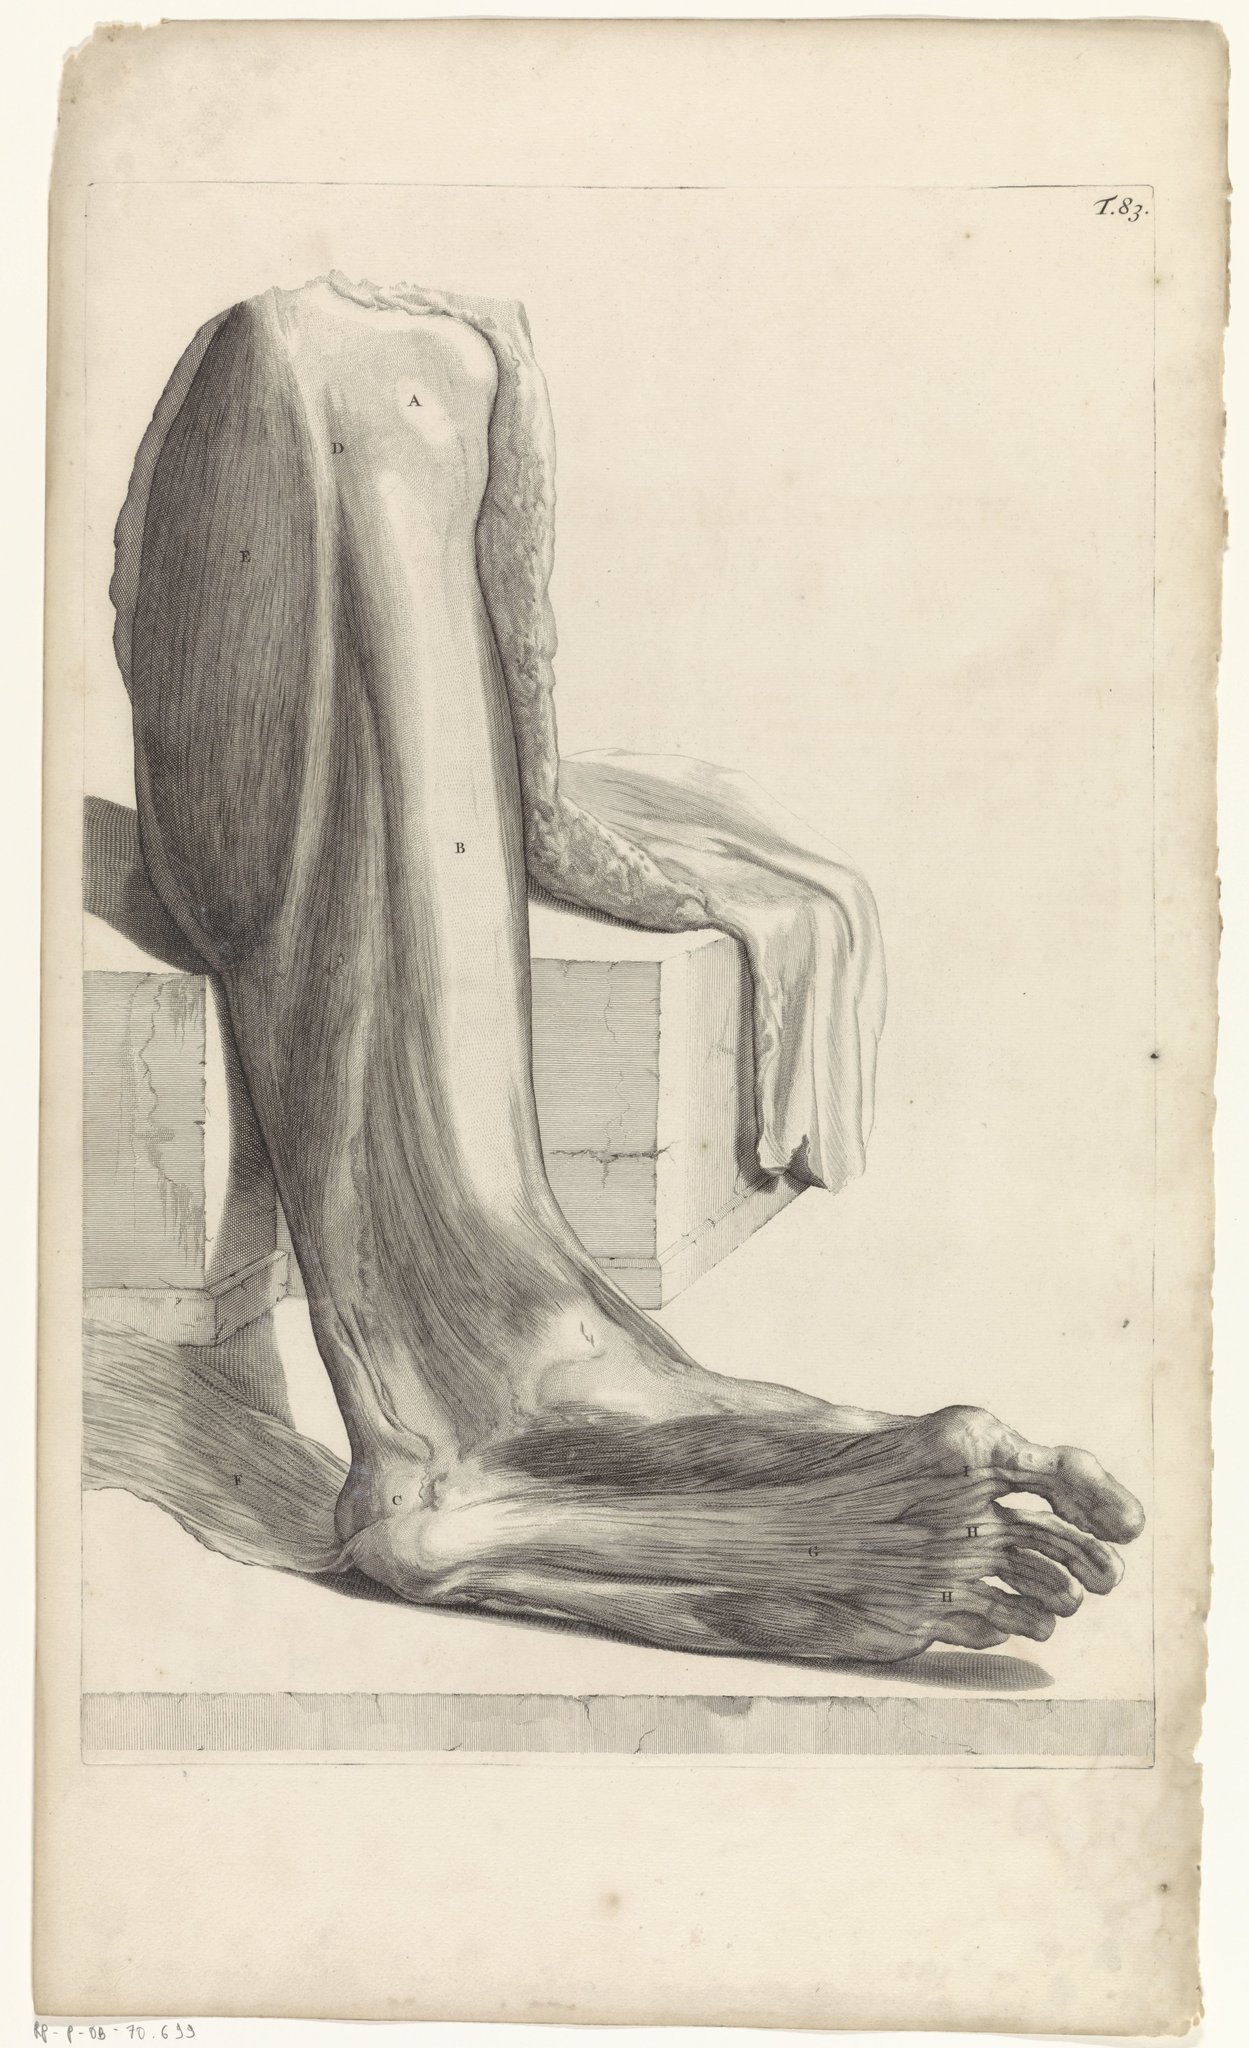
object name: print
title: Anatomische studie van de onderkant van de rechtervoet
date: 1685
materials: paper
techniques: engraving, etching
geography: amsterdam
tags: lower leg, muscles, foot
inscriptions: collector's mark: Lugt 2228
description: Boekillustratie voor Bidloo, Godefridus. Anatomia humani corporis centum & quinque tabulis, per art. G. de Lairesse ad vivum delineatis, de monstrata, veterum recentiorumque inventis explicata plurimisque, hactenus non detectis, illustrata. Amsterdam: Weduwe Joannes van Someren, Hendrick Boom en erven Dirk Boom, 1685.